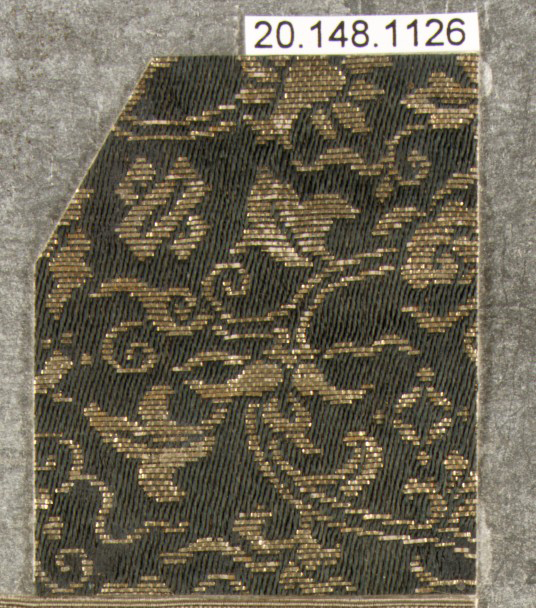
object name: piece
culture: japanese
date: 1801-1900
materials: silk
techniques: compound weave